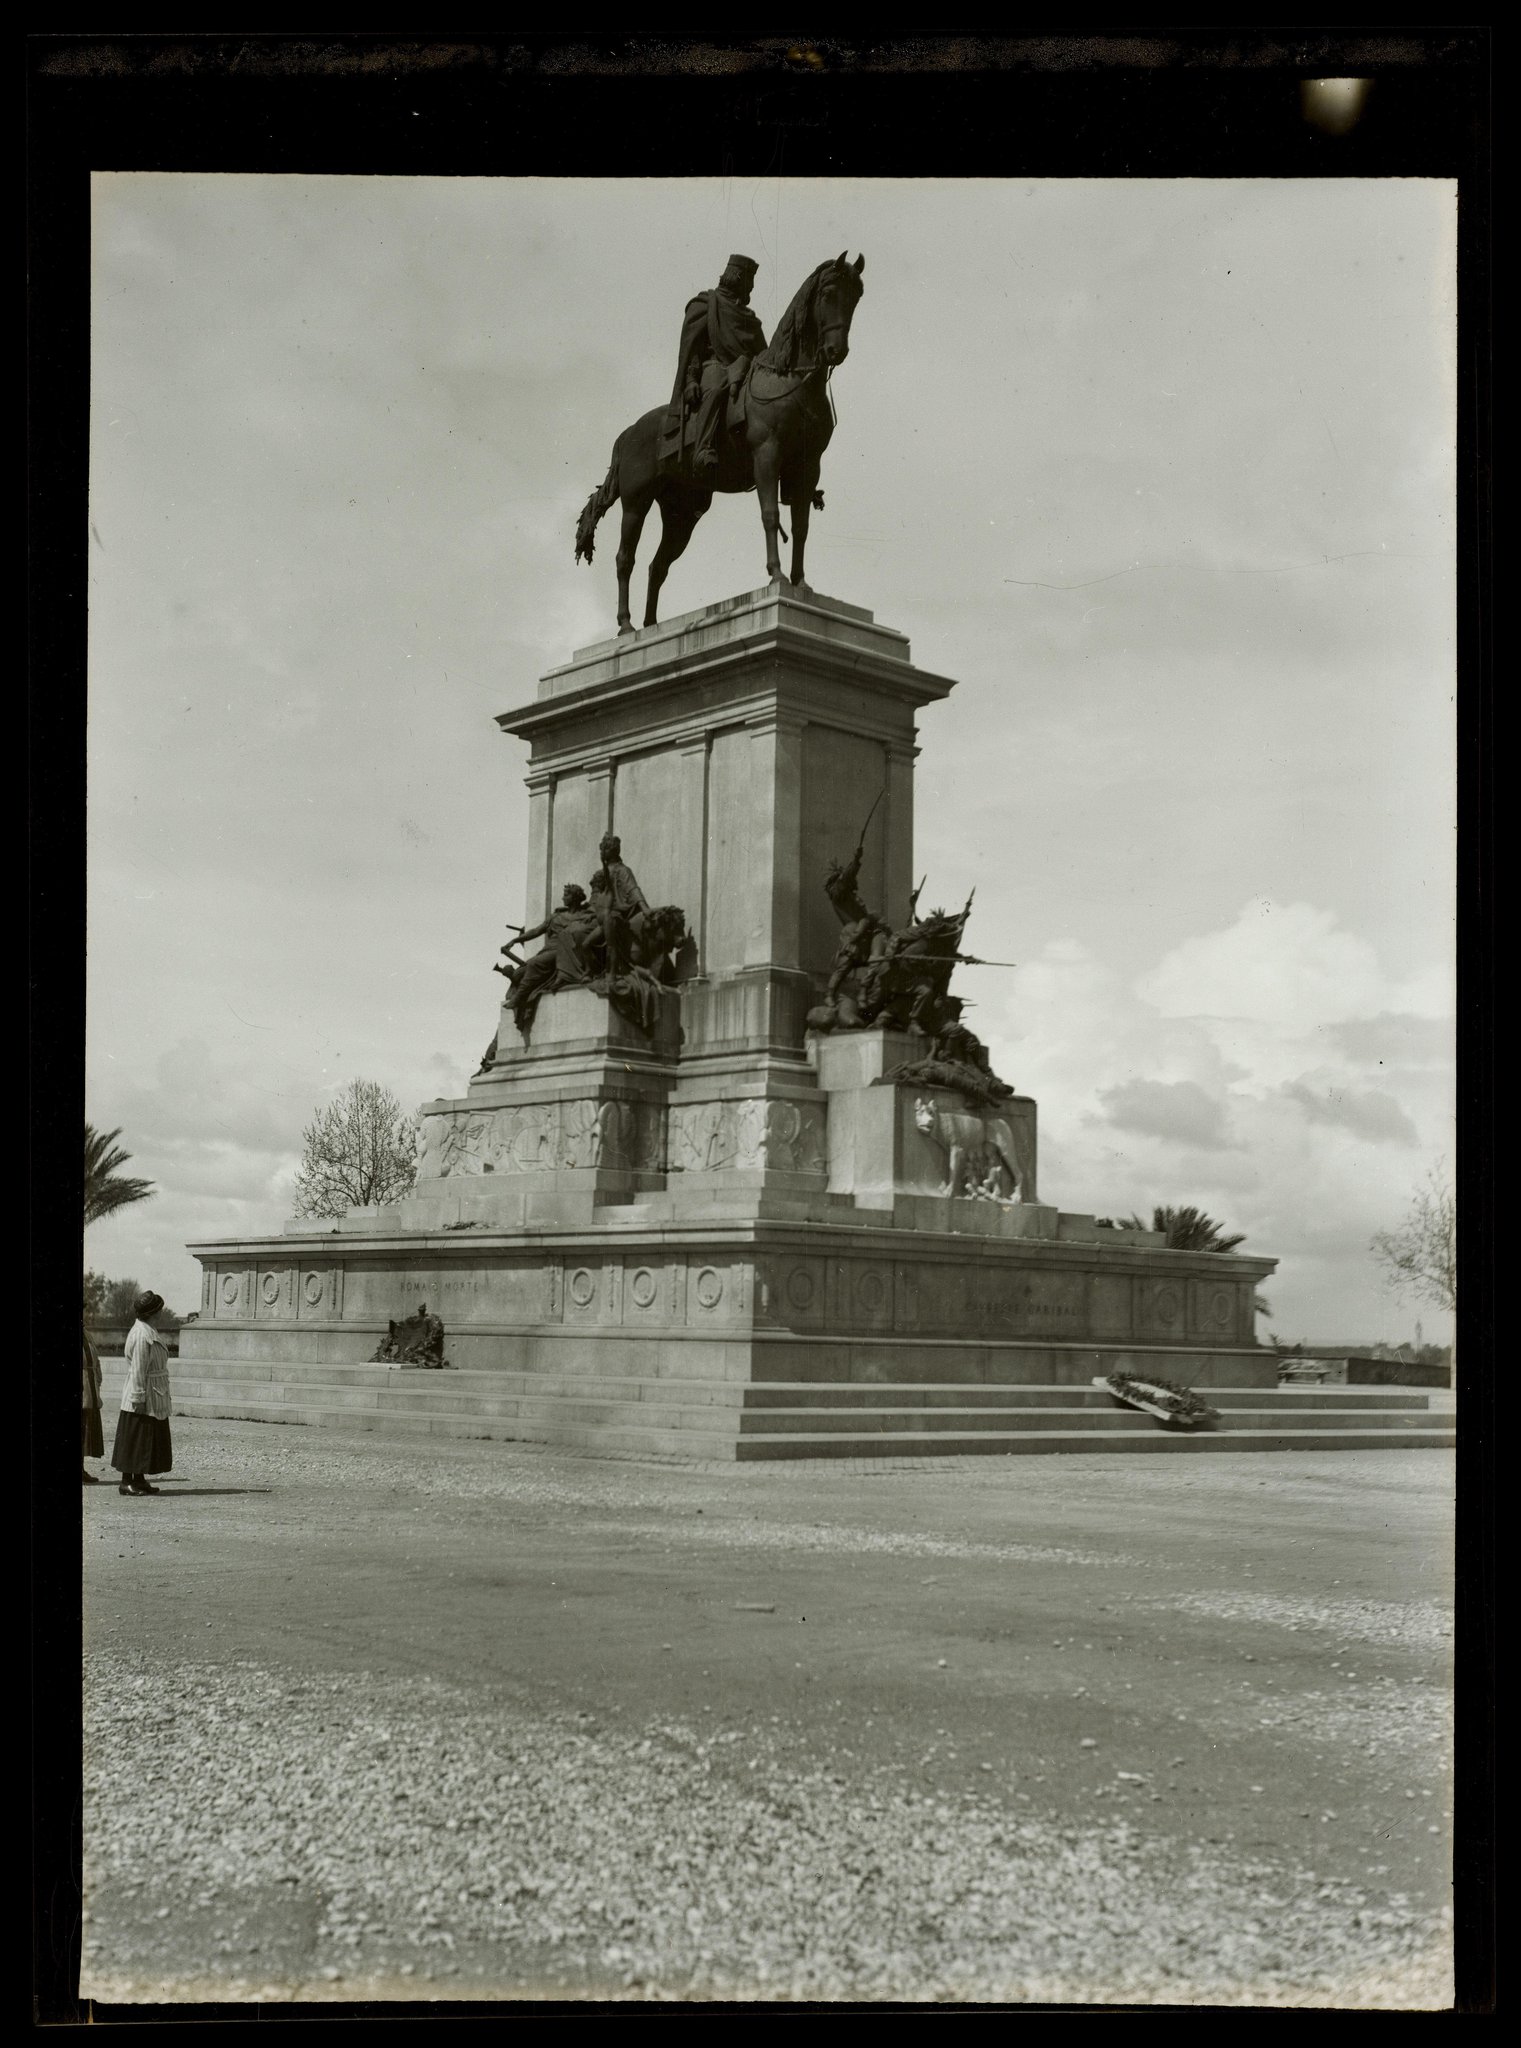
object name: negative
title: Filmnegatief met opname van Rome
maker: Anonymous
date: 1907-1935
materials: film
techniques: gelatin silver negative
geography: rome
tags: rome